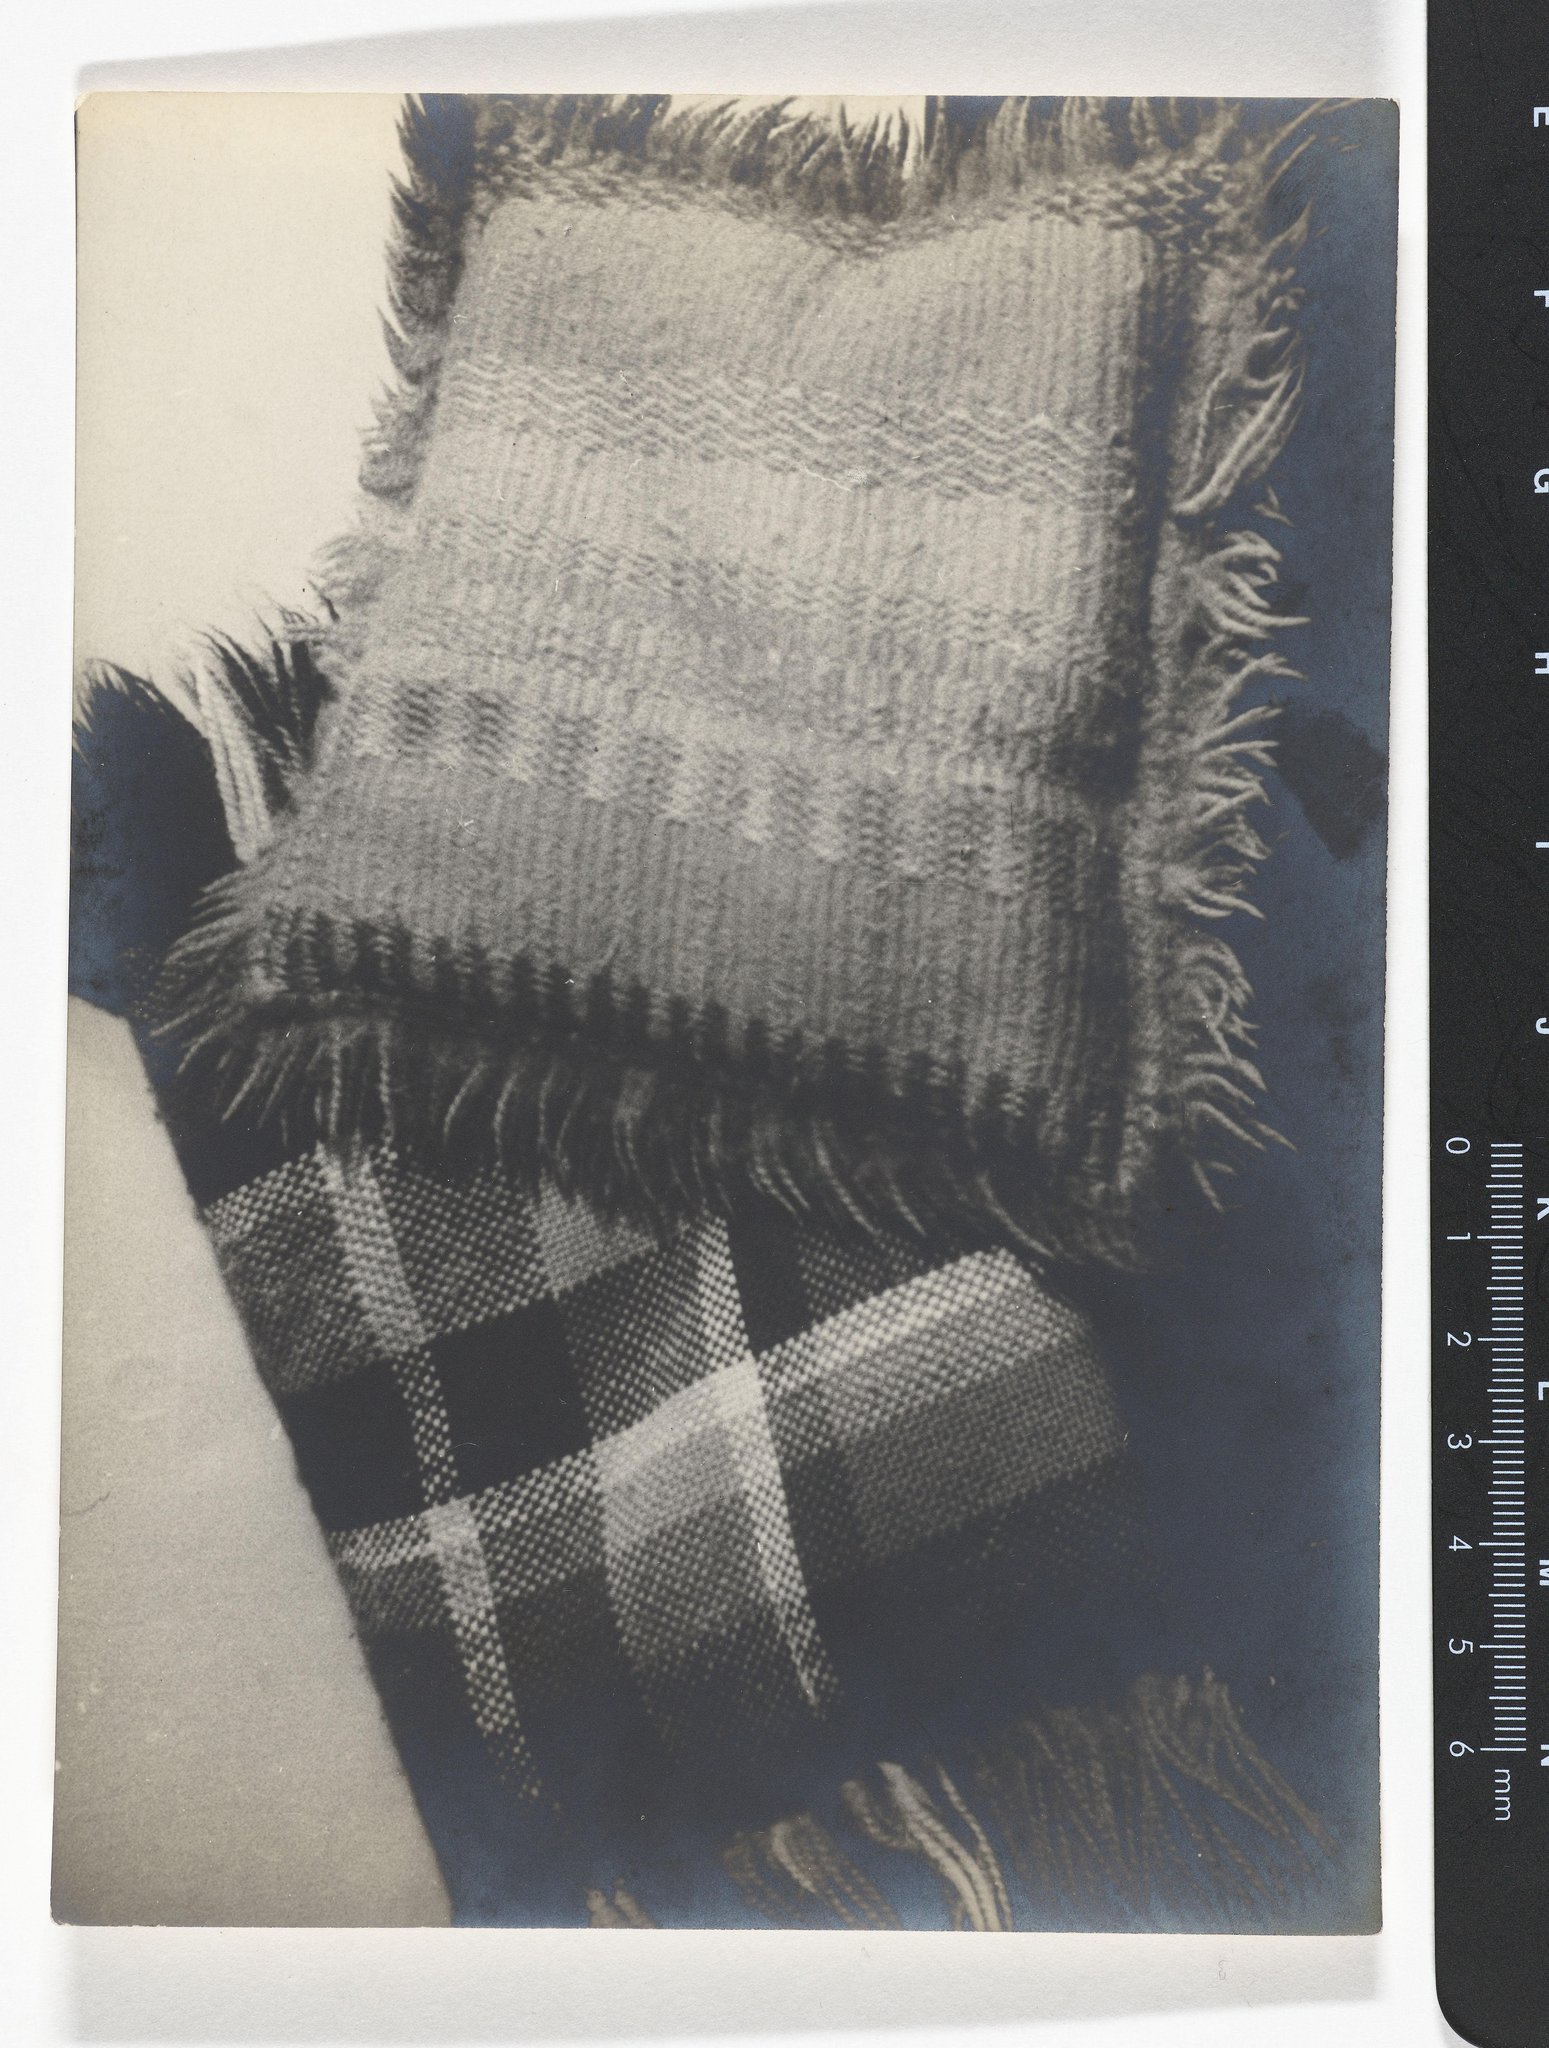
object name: photograph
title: Twee geweven kussens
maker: kurt kahle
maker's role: fotograaf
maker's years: 1897-1953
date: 1935-1940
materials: paper, photographic support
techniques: gelatin silver print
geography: amsterdam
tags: cushion, textile fabric, cloth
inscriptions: inscription: ‘Het bonte schaap / Jeanne Scheffer / kussens in wol’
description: De kussen zijn in aardkleuren en zwart-wit, ontworpen door Jeanne van Gelder-Scheffer